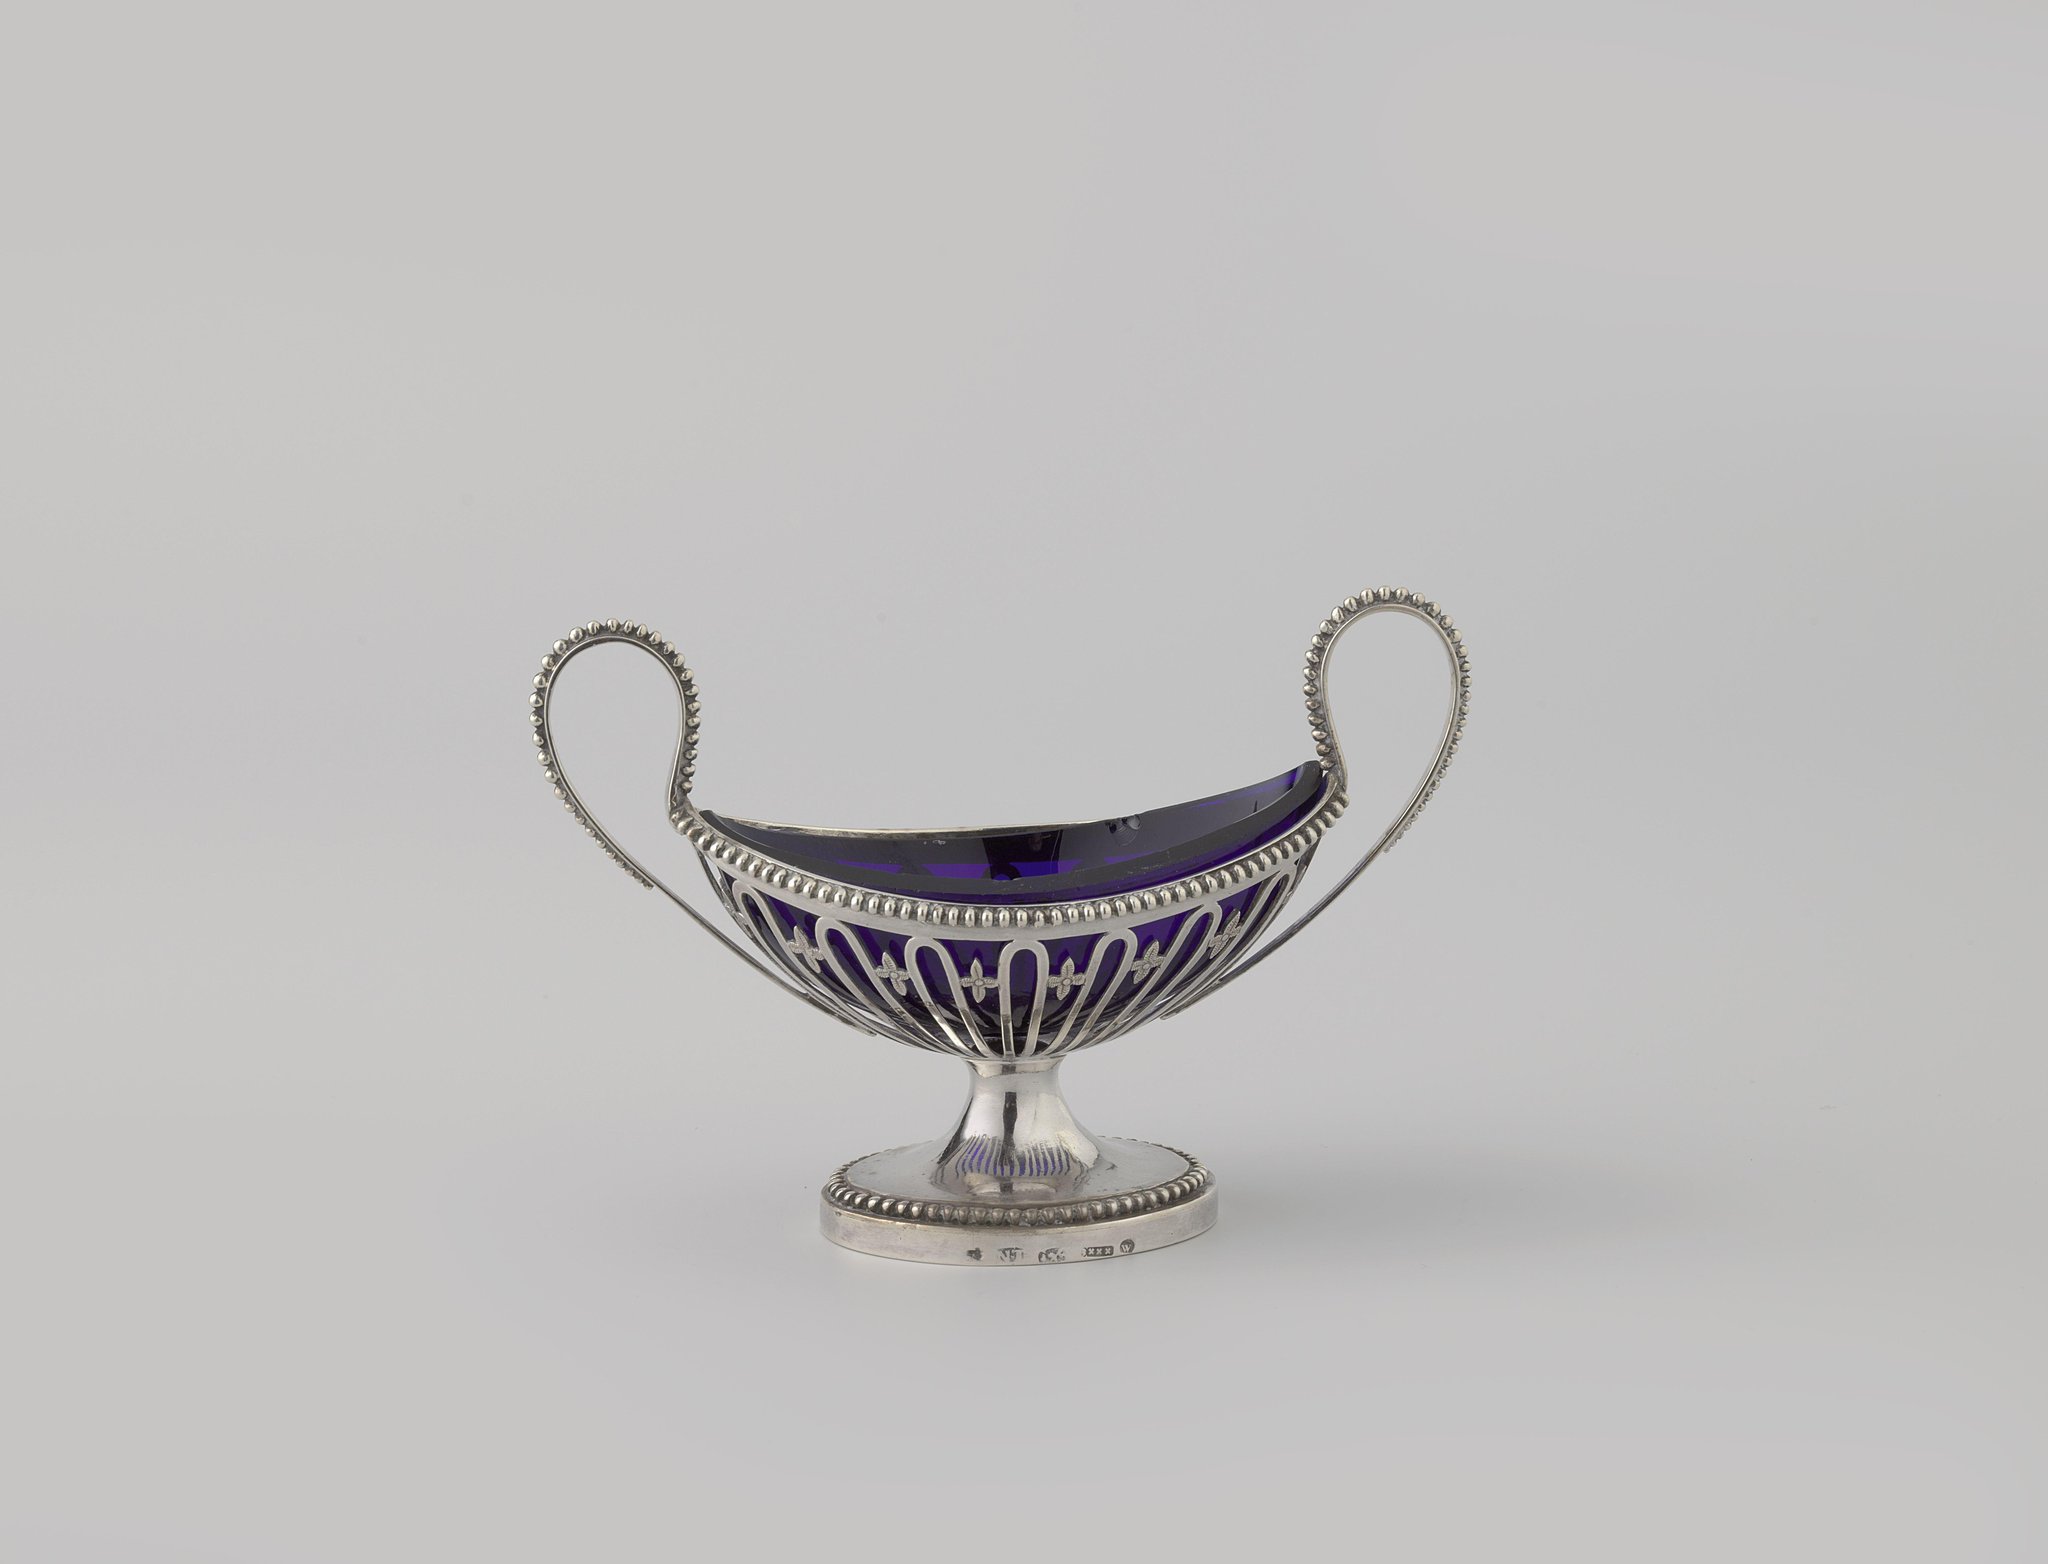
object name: salt condiment vessel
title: Binnenbak van blauw glas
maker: nathanael teuter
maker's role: silversmith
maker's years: 1767-1831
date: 1805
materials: glass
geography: amsterdam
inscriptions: town mark, alloy mark, maker's mark, duty mark, date letter: ‘W’